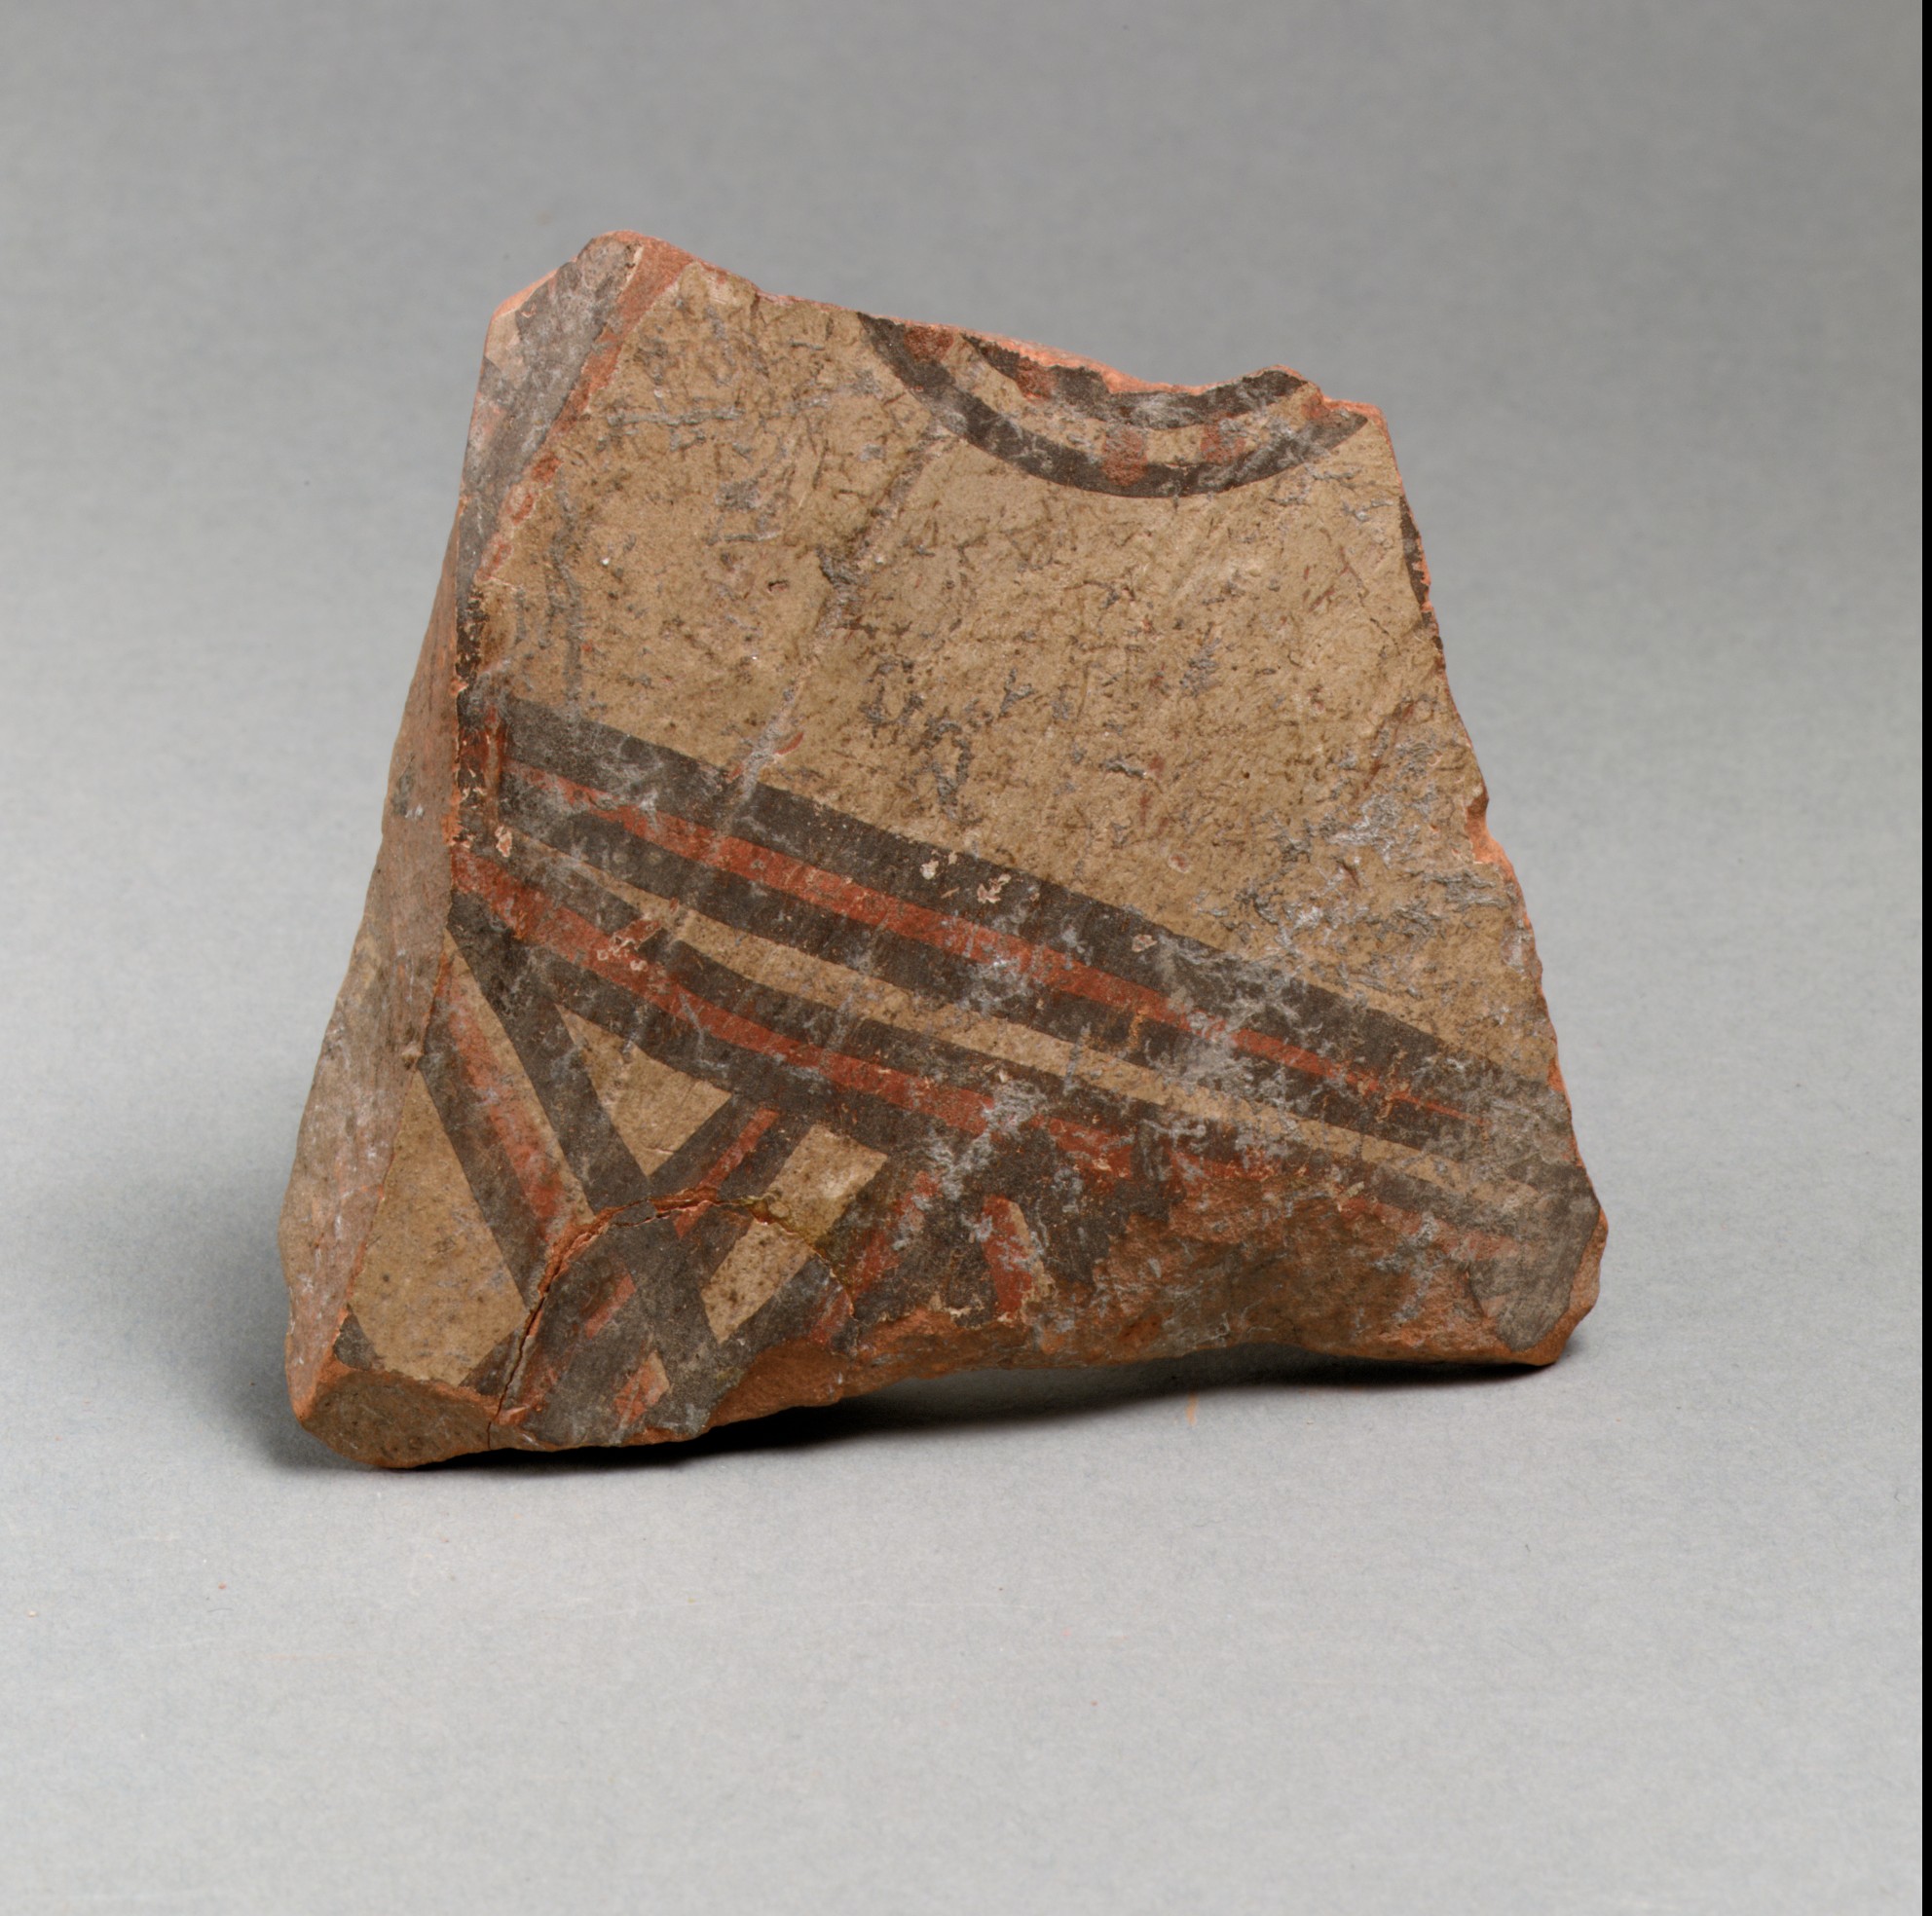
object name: vase fragment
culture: greek or lydian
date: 800-480 BCE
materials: terracotta